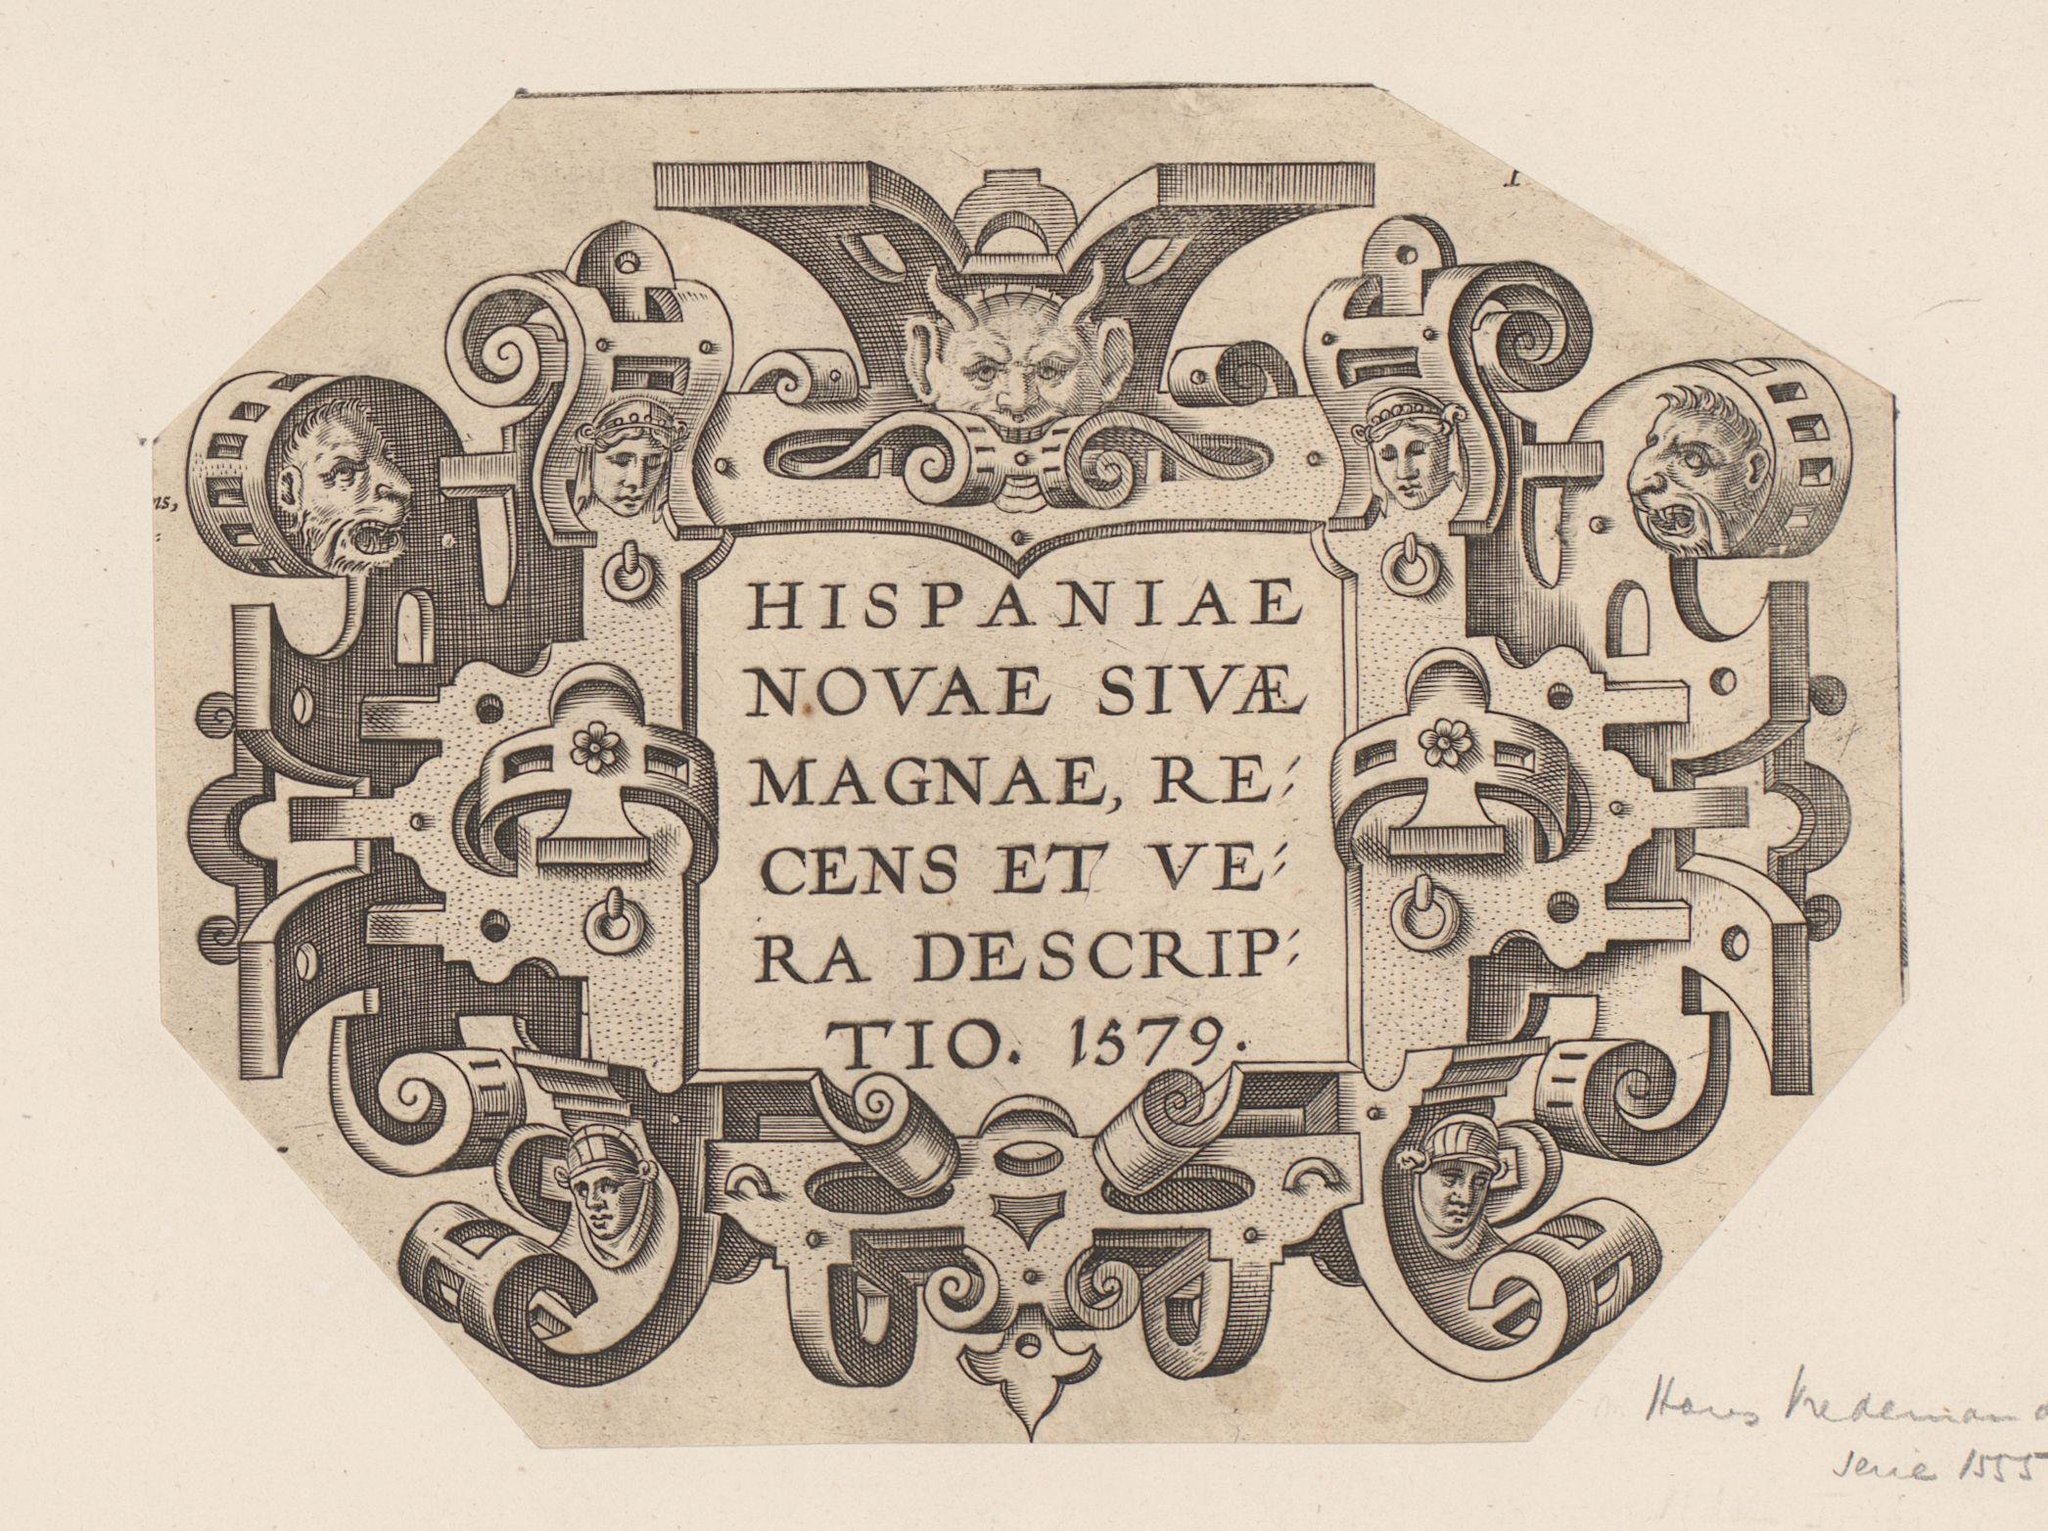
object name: ornament print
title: Hispaniae Novae Sivae Magnae, Recens et Vera Descriptio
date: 1579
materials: paper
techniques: engraving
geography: antwerp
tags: ornament ~ cartouche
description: Vierkante cartouche met bovenaan het hoofd van een sater die zijn tanden in het rolwerk zet. Links en rechts een leeuwenkop. De cartouche is een fragment van een kaart van Spanje. De prent maakt deel uit van een album.